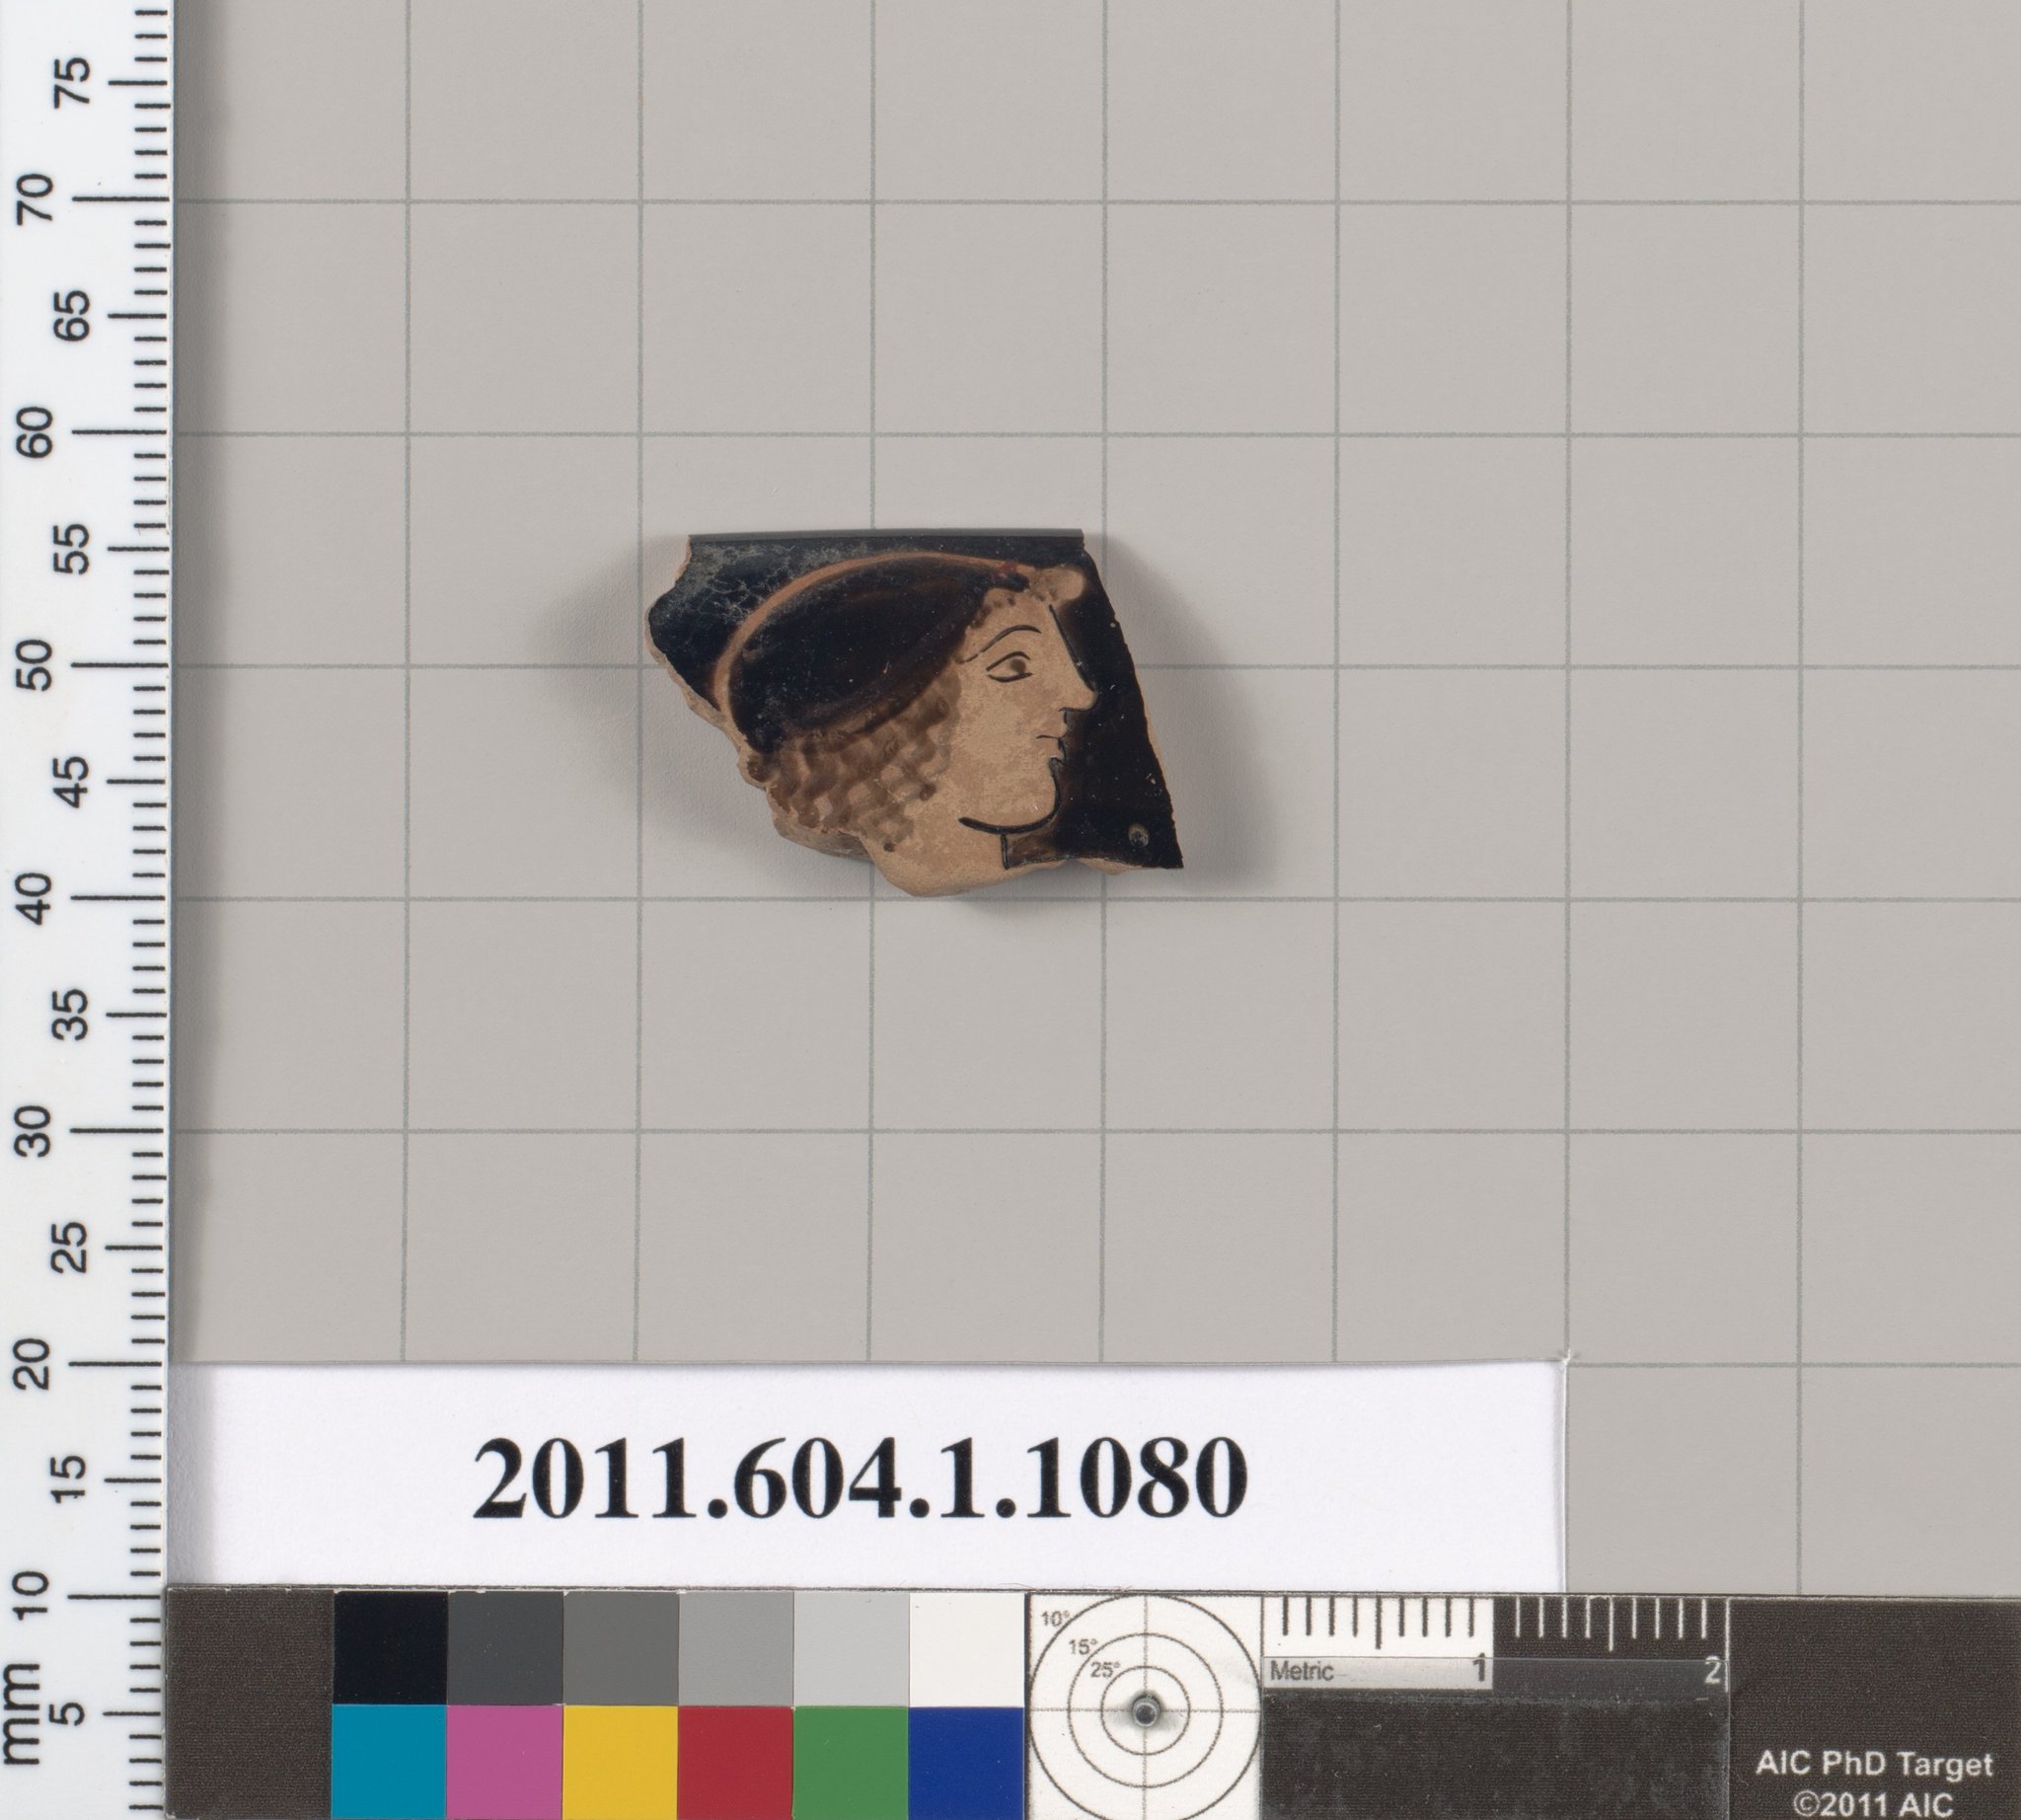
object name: kylix fragment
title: Terracotta rim fragment of a kylix (drinking cup)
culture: greek, attic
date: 470-460 BCE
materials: terracotta